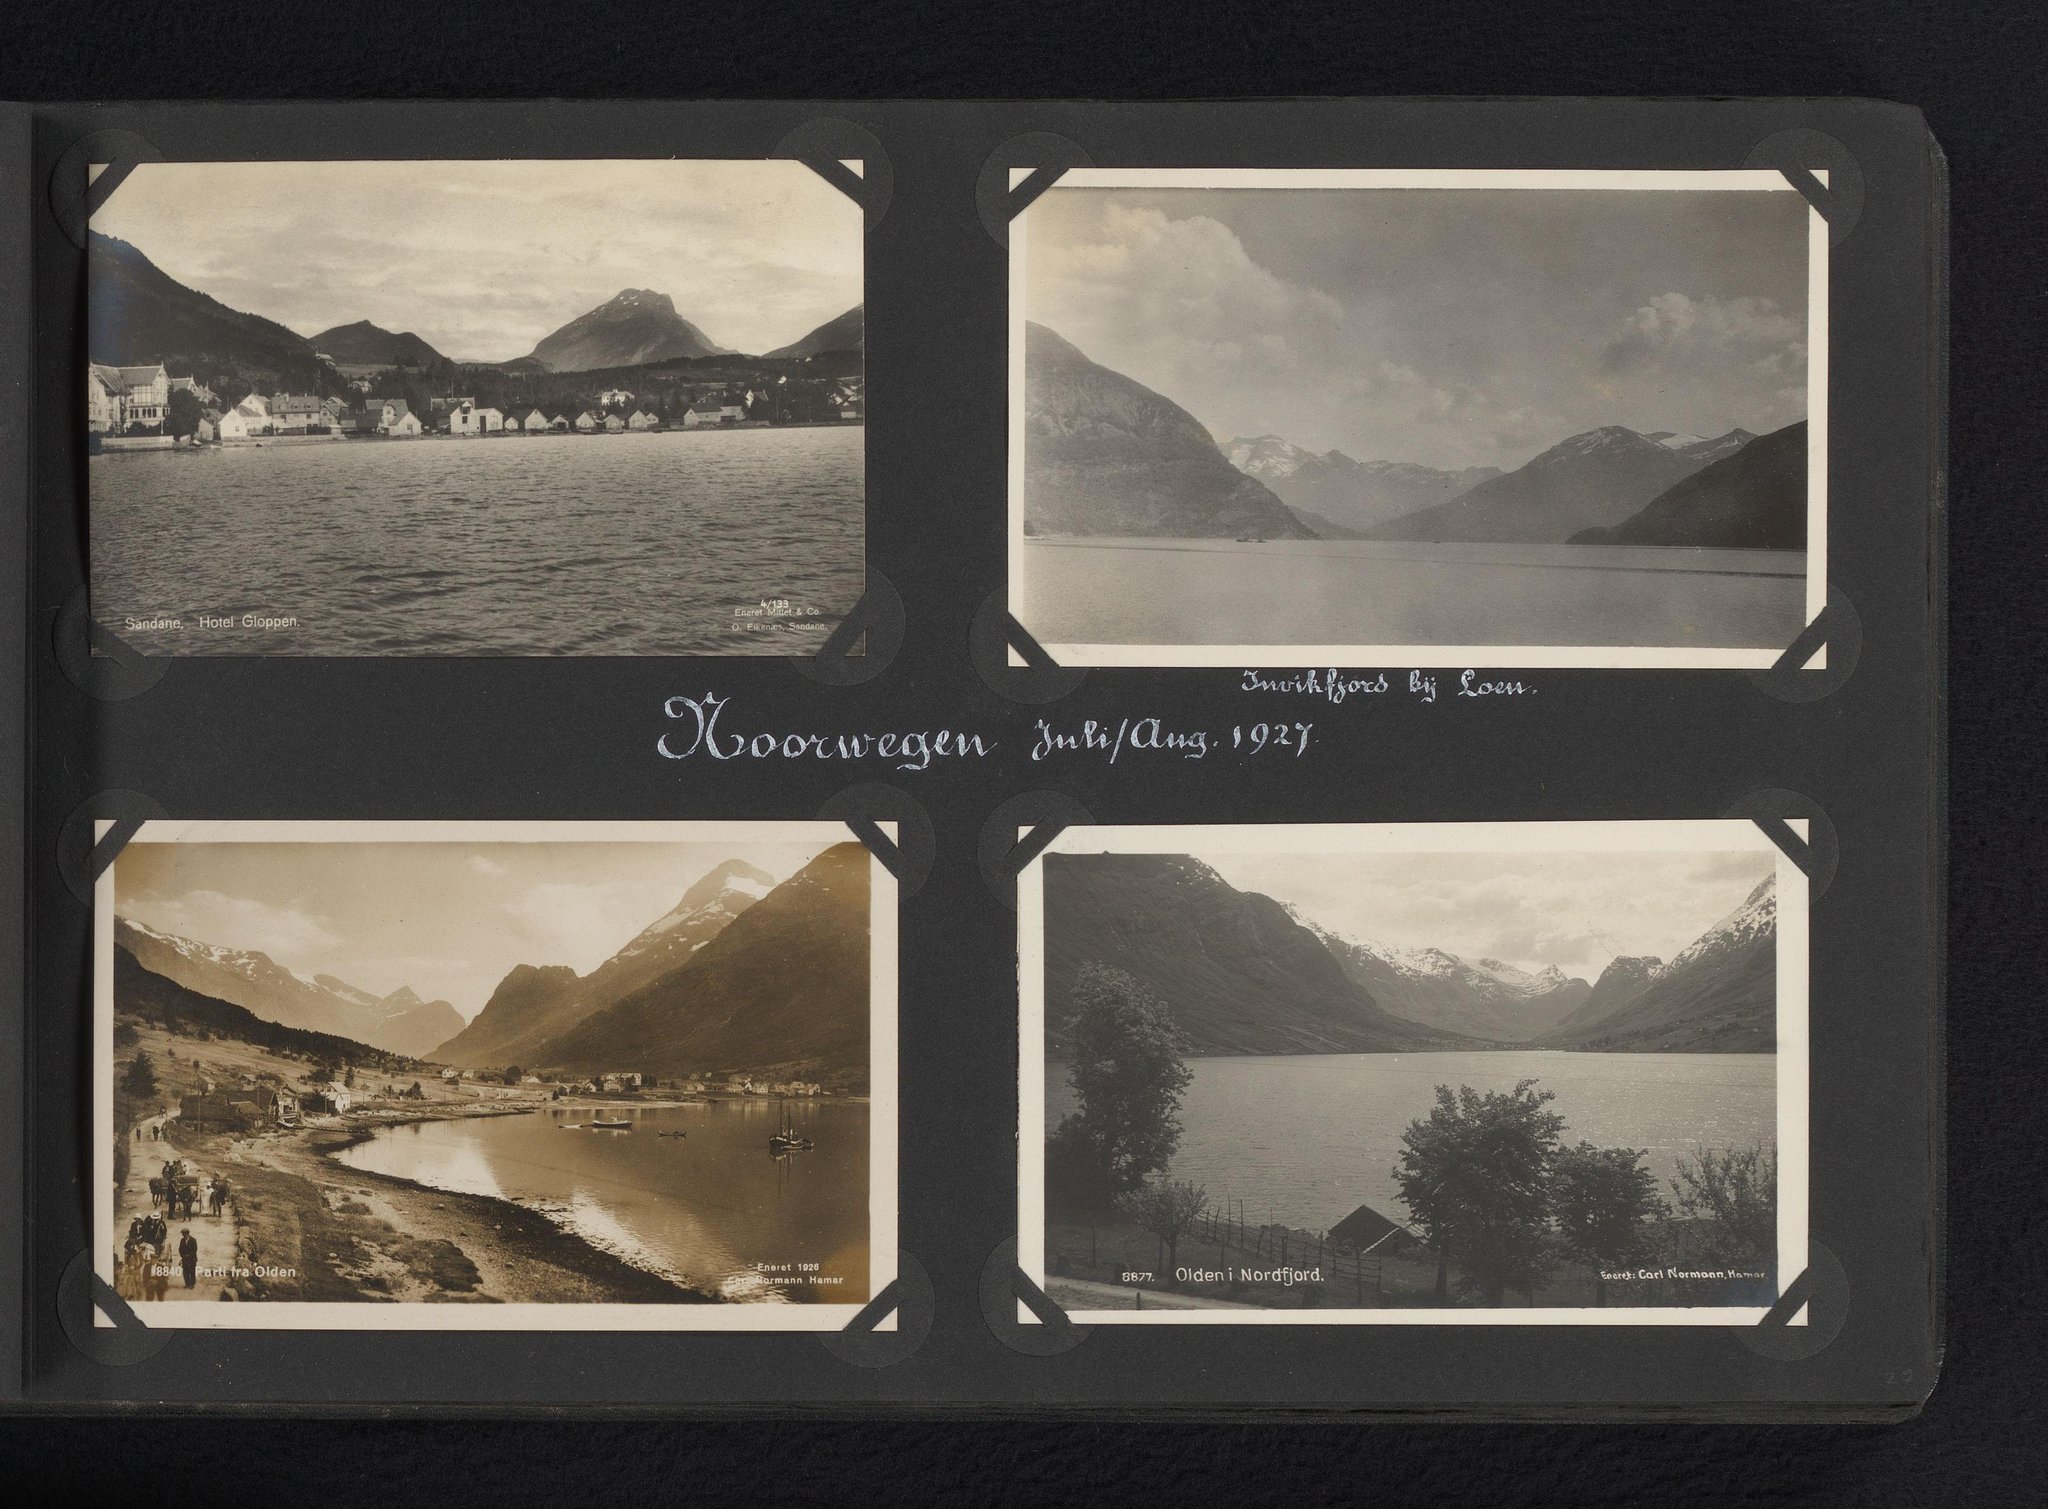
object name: photograph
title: Vier foto's, waarvan drie prentbriefkaarten, van Sandane en Olden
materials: paper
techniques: gelatin silver print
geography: norway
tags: village, lake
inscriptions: inscription: ‘Invikfjord bij Loen’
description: Deze foto's maken deel uit van een album.